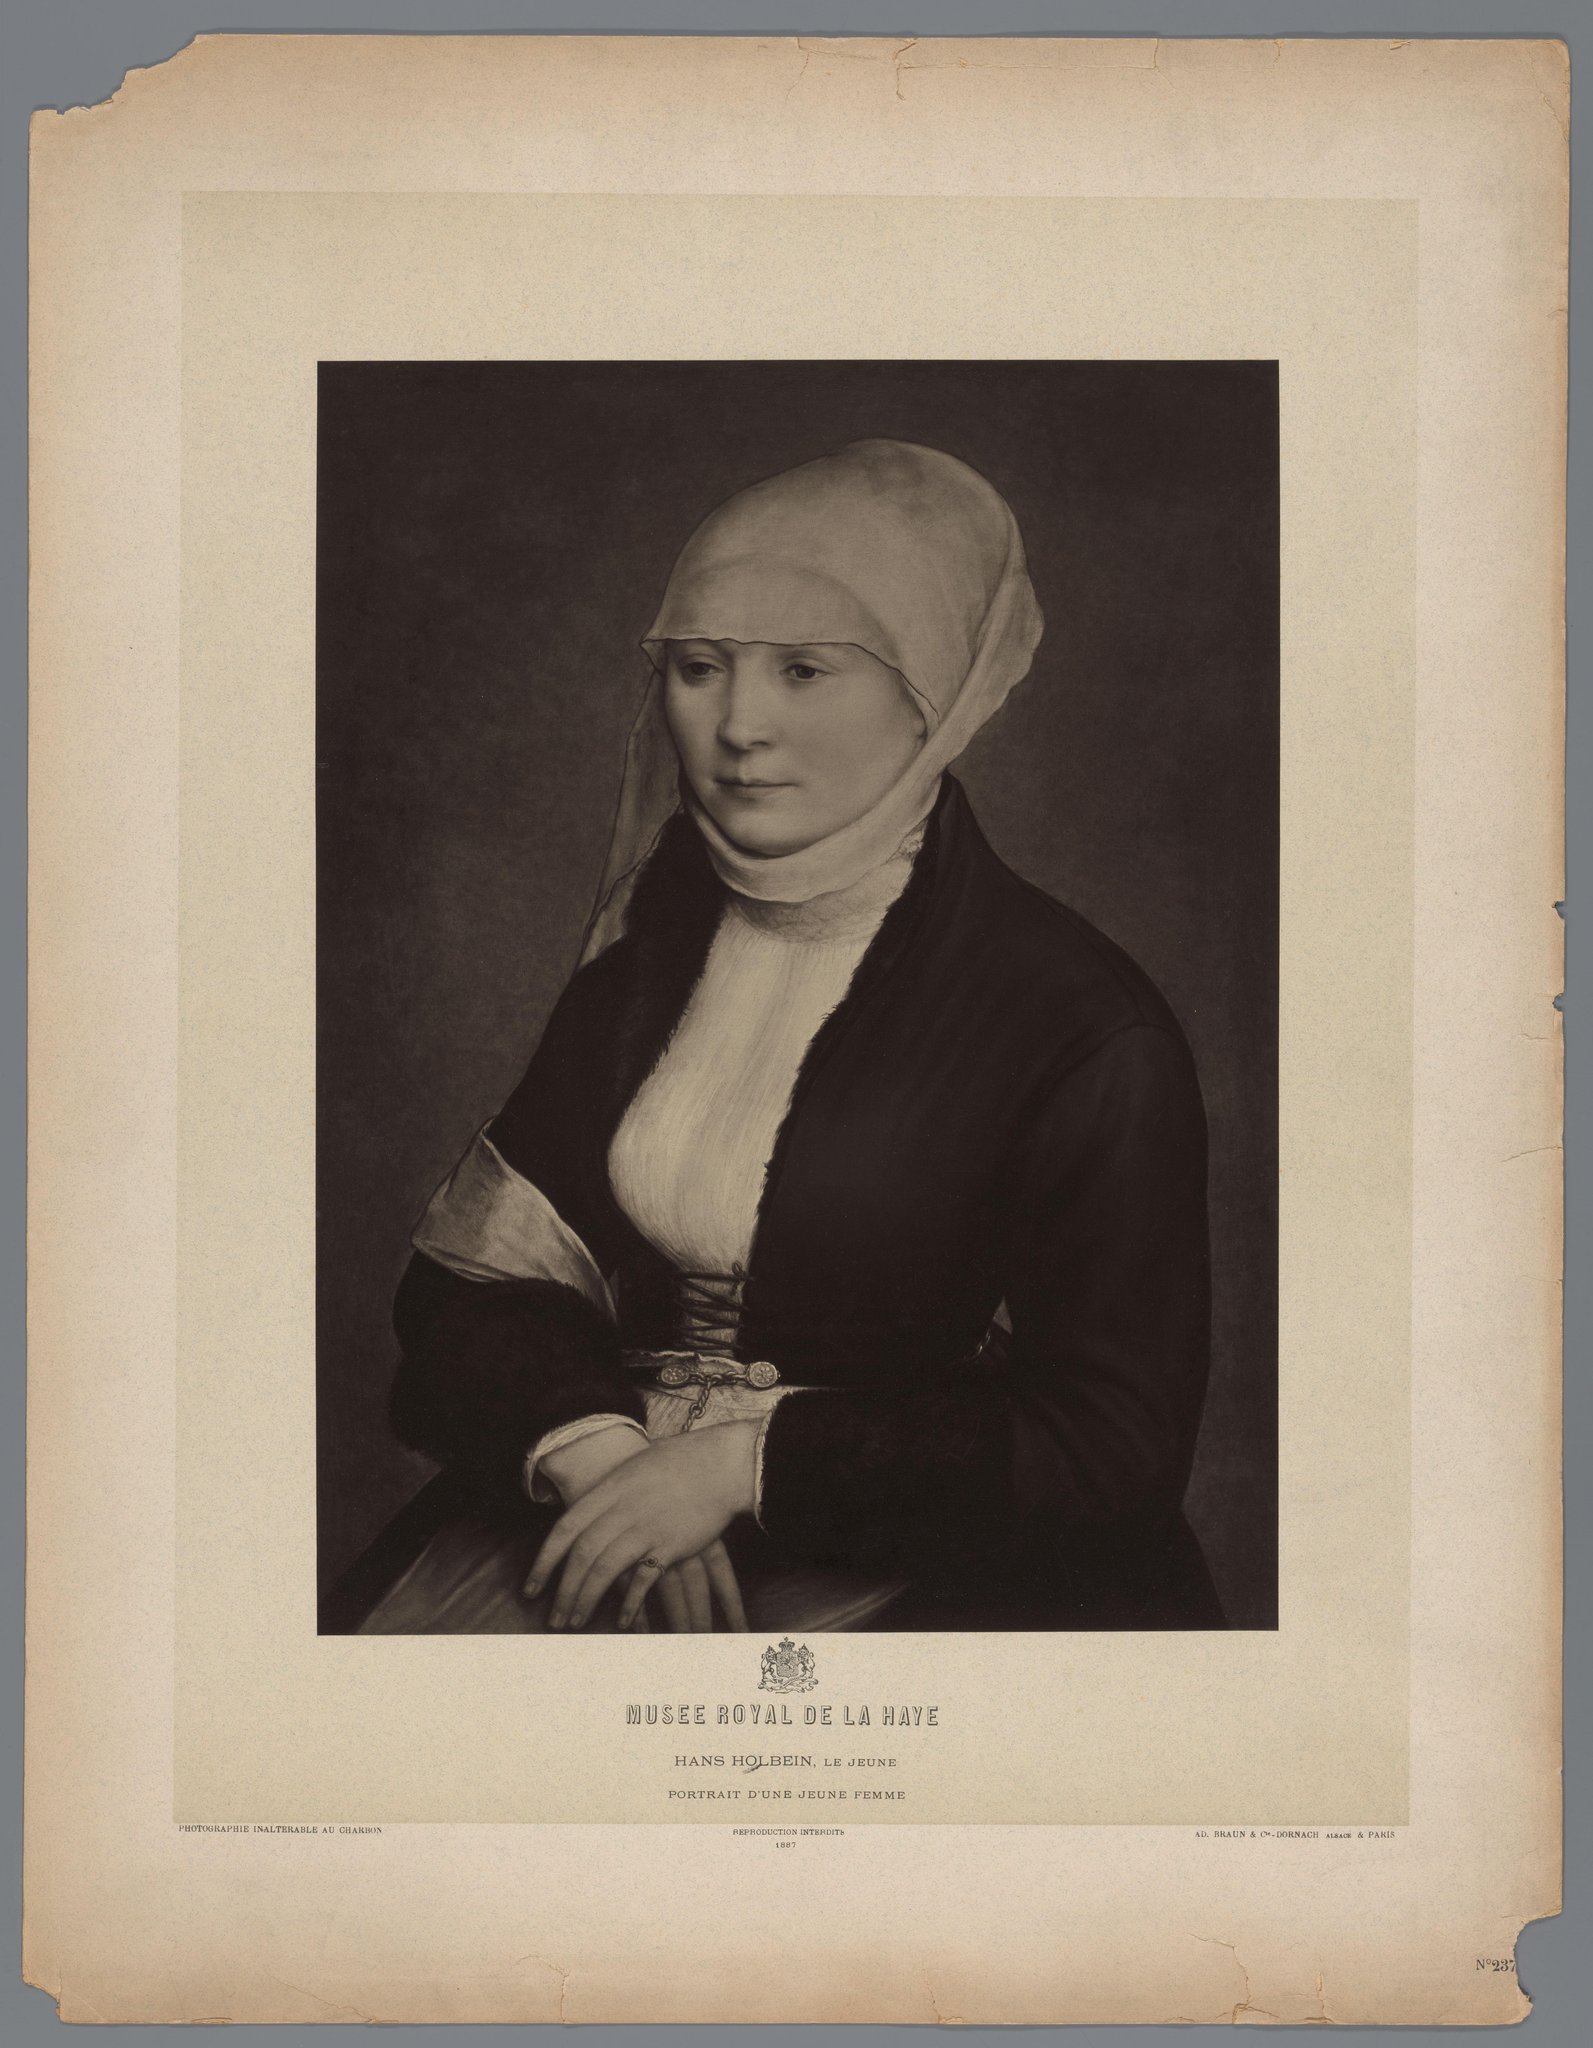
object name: photograph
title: Fotoreproductie van een schilderij van Hans Holbein de Jongere, 'Portret van een jonge vrouw' (coll. Mauritshuis)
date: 1887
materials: cardboard, paper, photographic support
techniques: carbon print